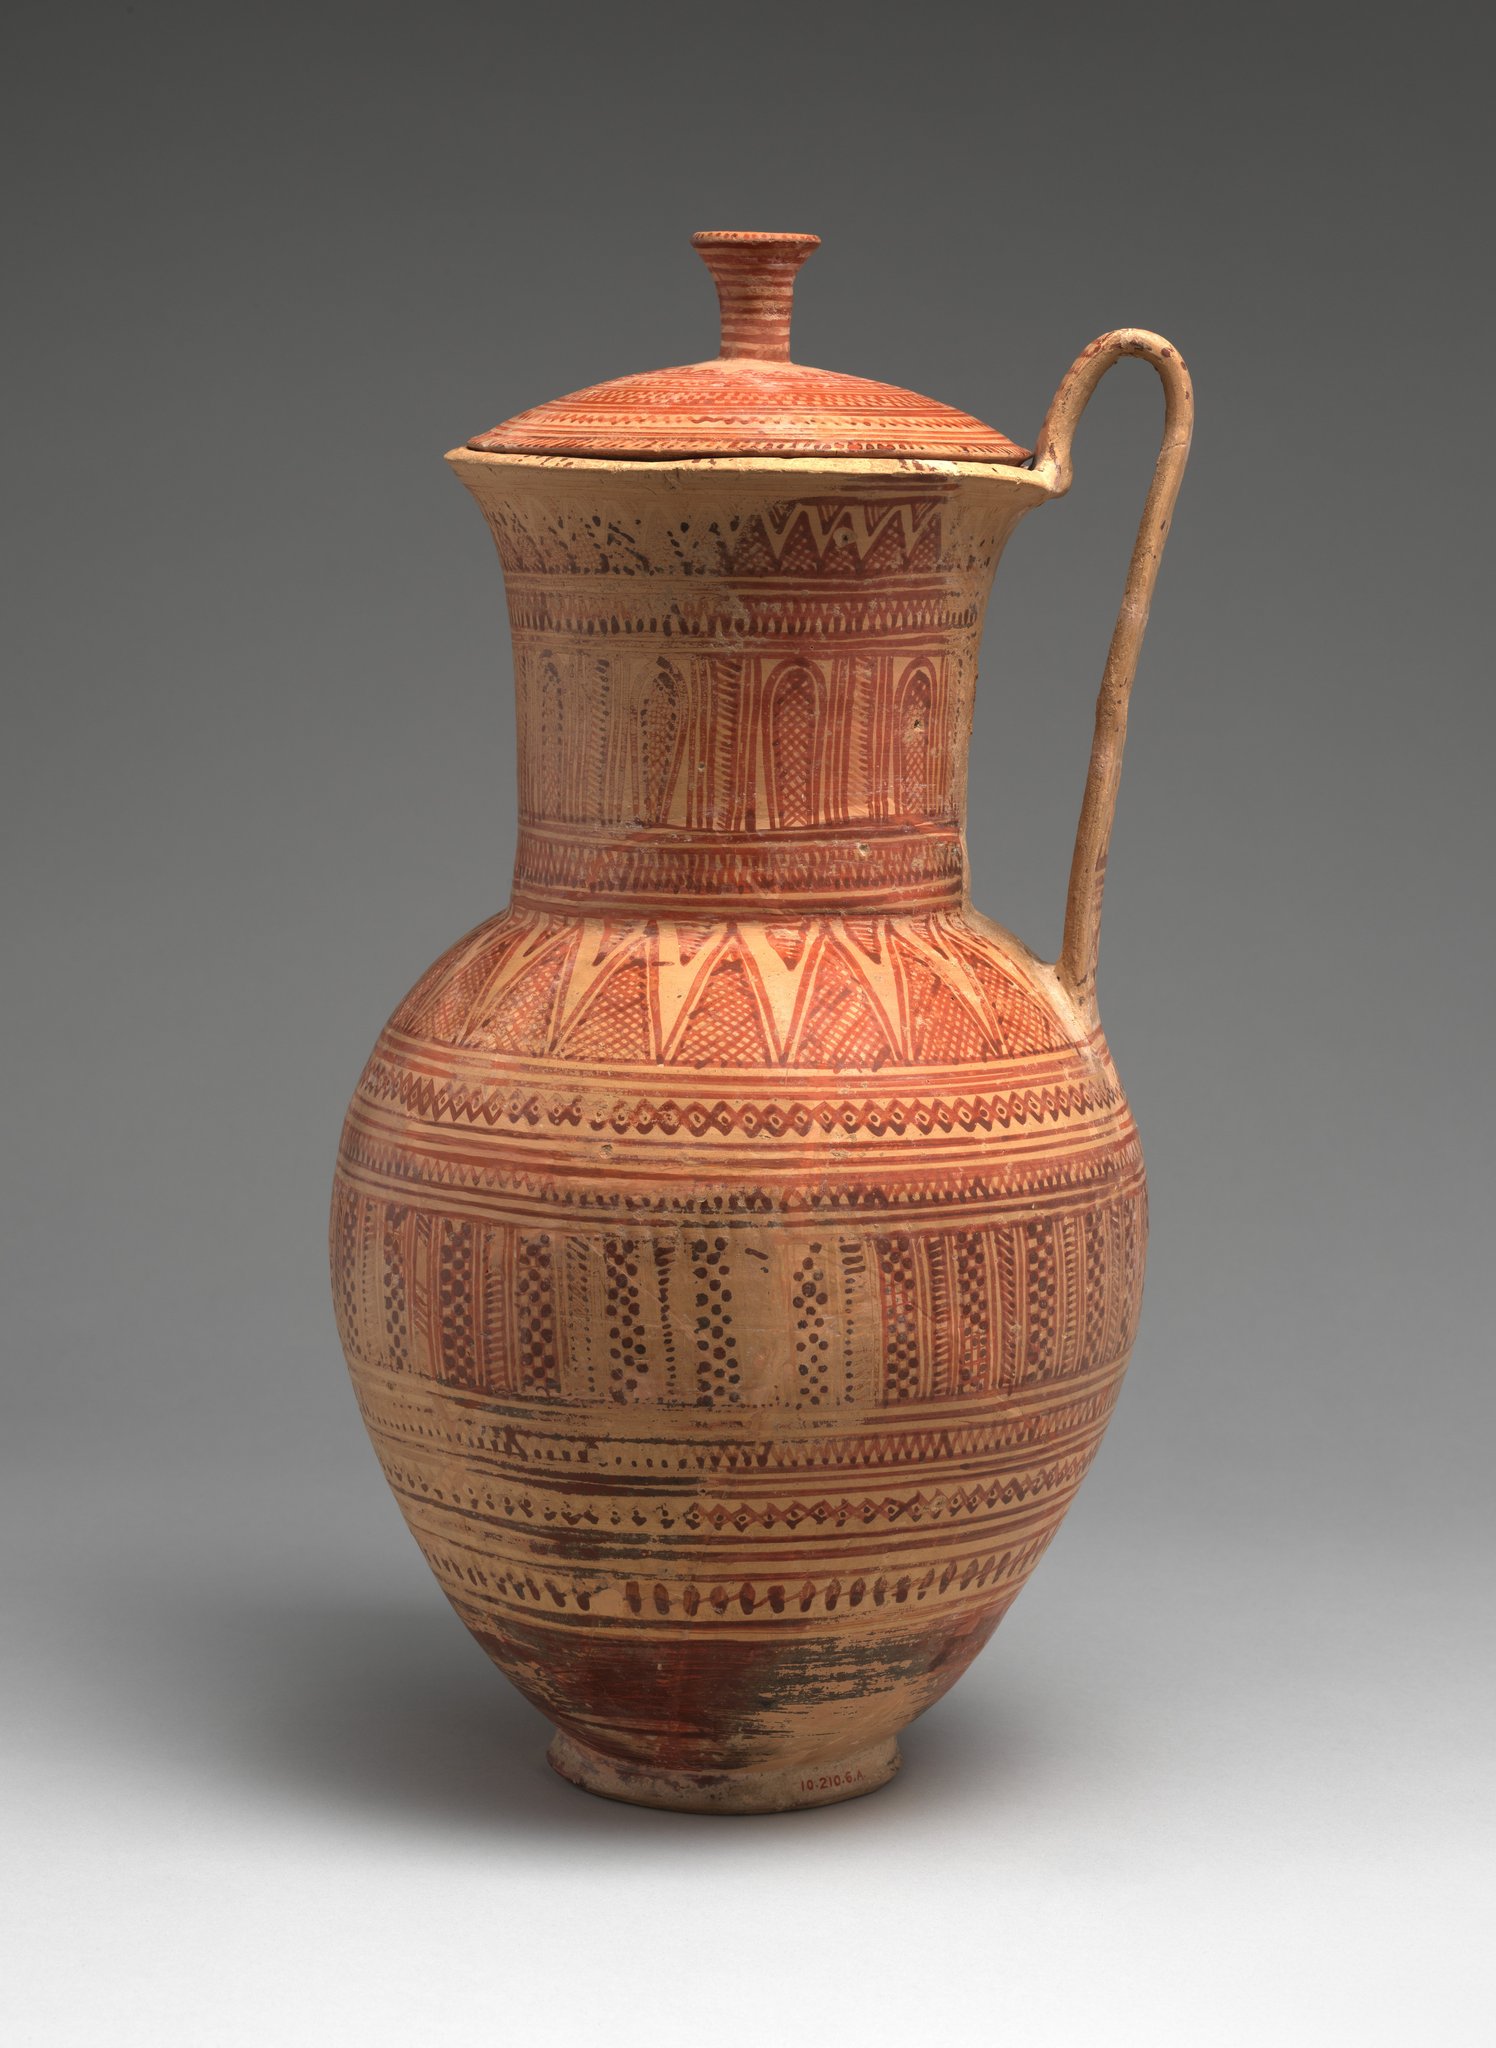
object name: oinochoe with lid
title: Terracotta pitcher with lid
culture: greek, attic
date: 730 BCE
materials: terracotta